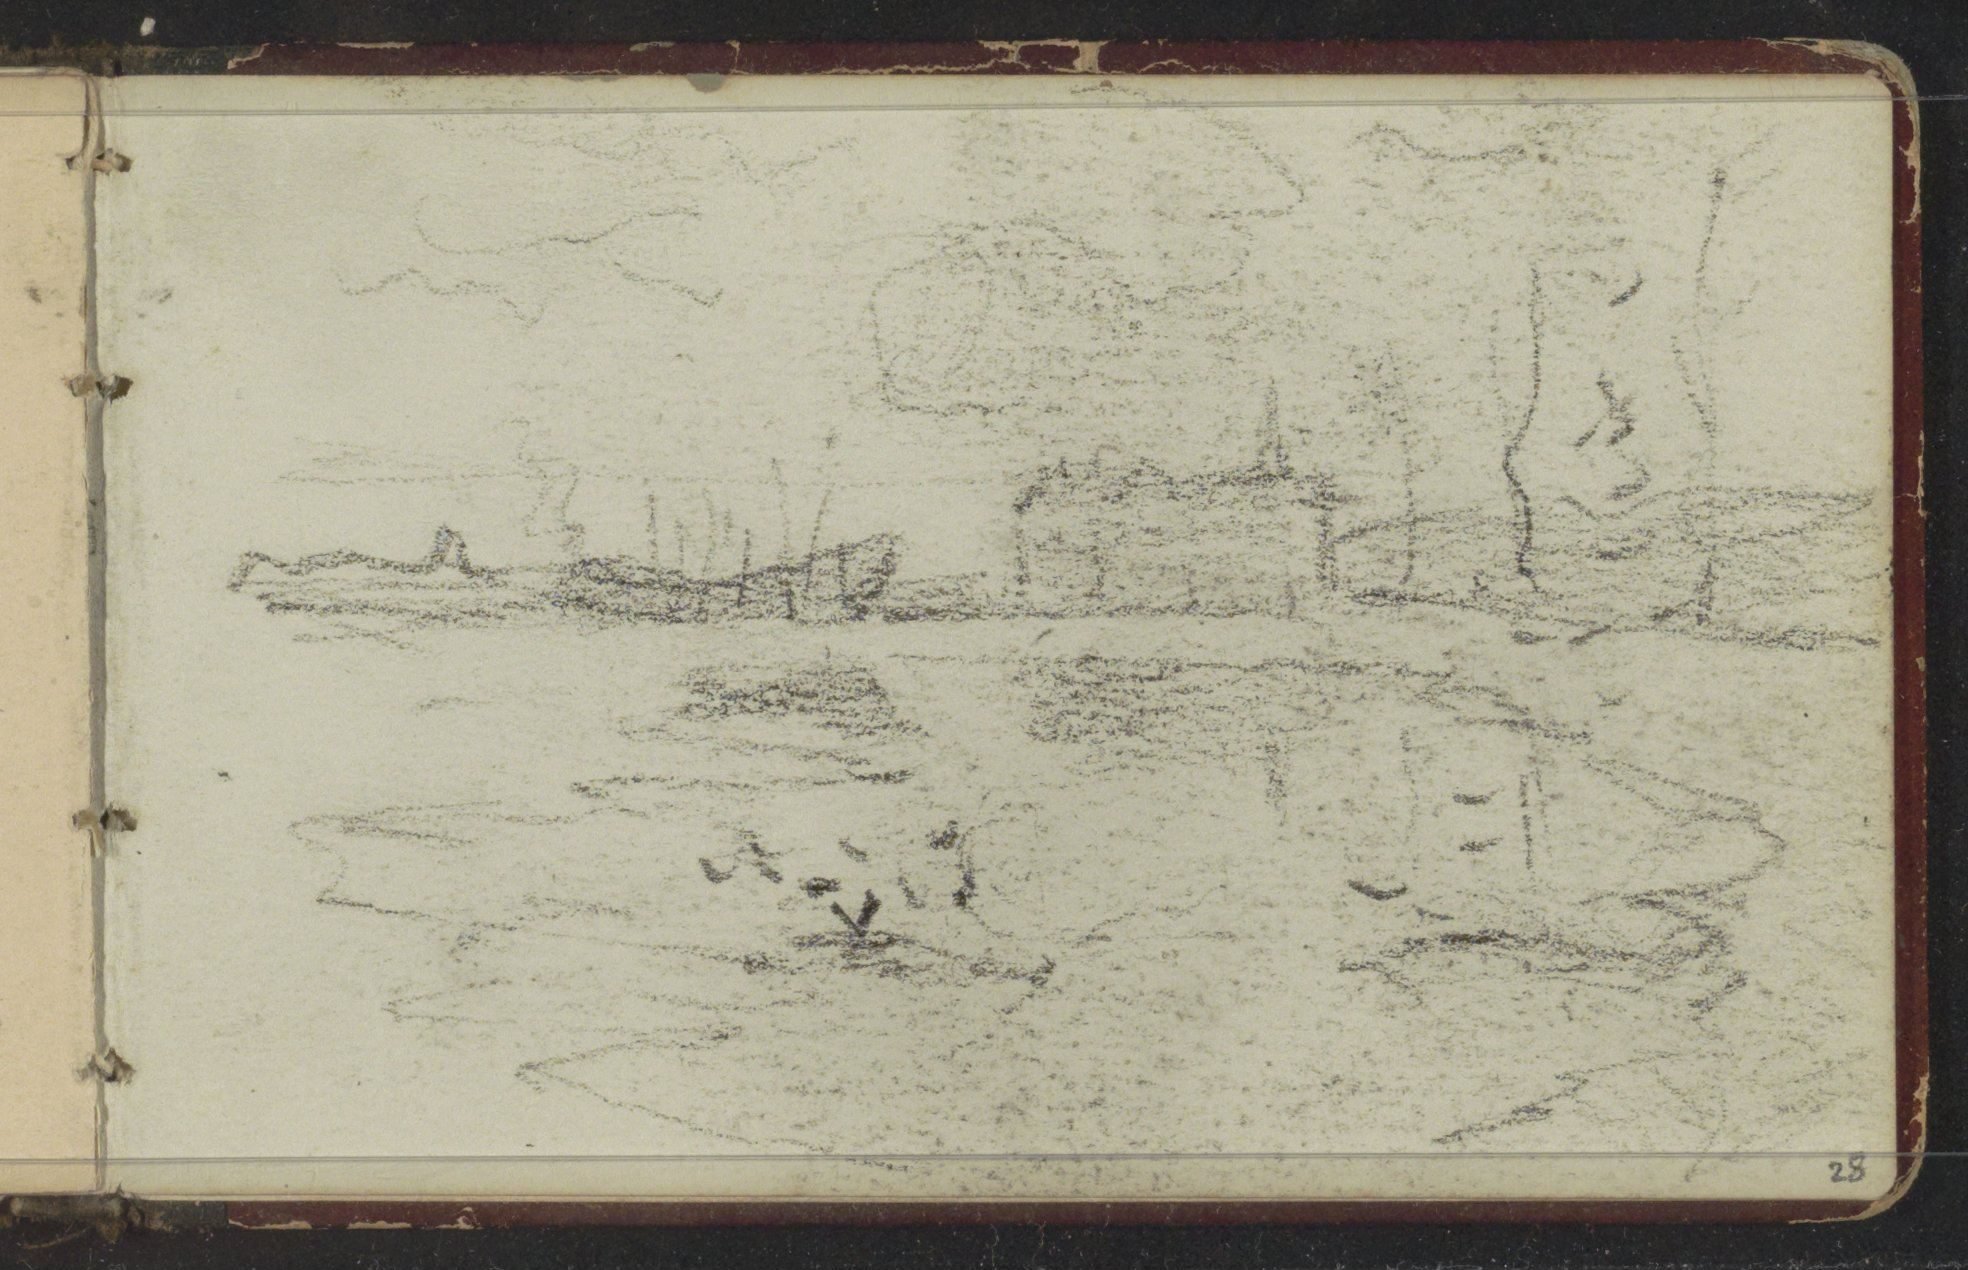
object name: sketchbook leaf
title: Landschap met een gebouw aan een waterkant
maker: willem cornelis rip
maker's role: draughtsman, painter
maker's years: 1856-1922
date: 1891-1892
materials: chalk, paper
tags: city-view, and landscape with man-made constructions, landscapes with waters, waterscapes, seascapes (in the temperate zone)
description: Blad 28 recto uit een schetsboek met 28 bladen.